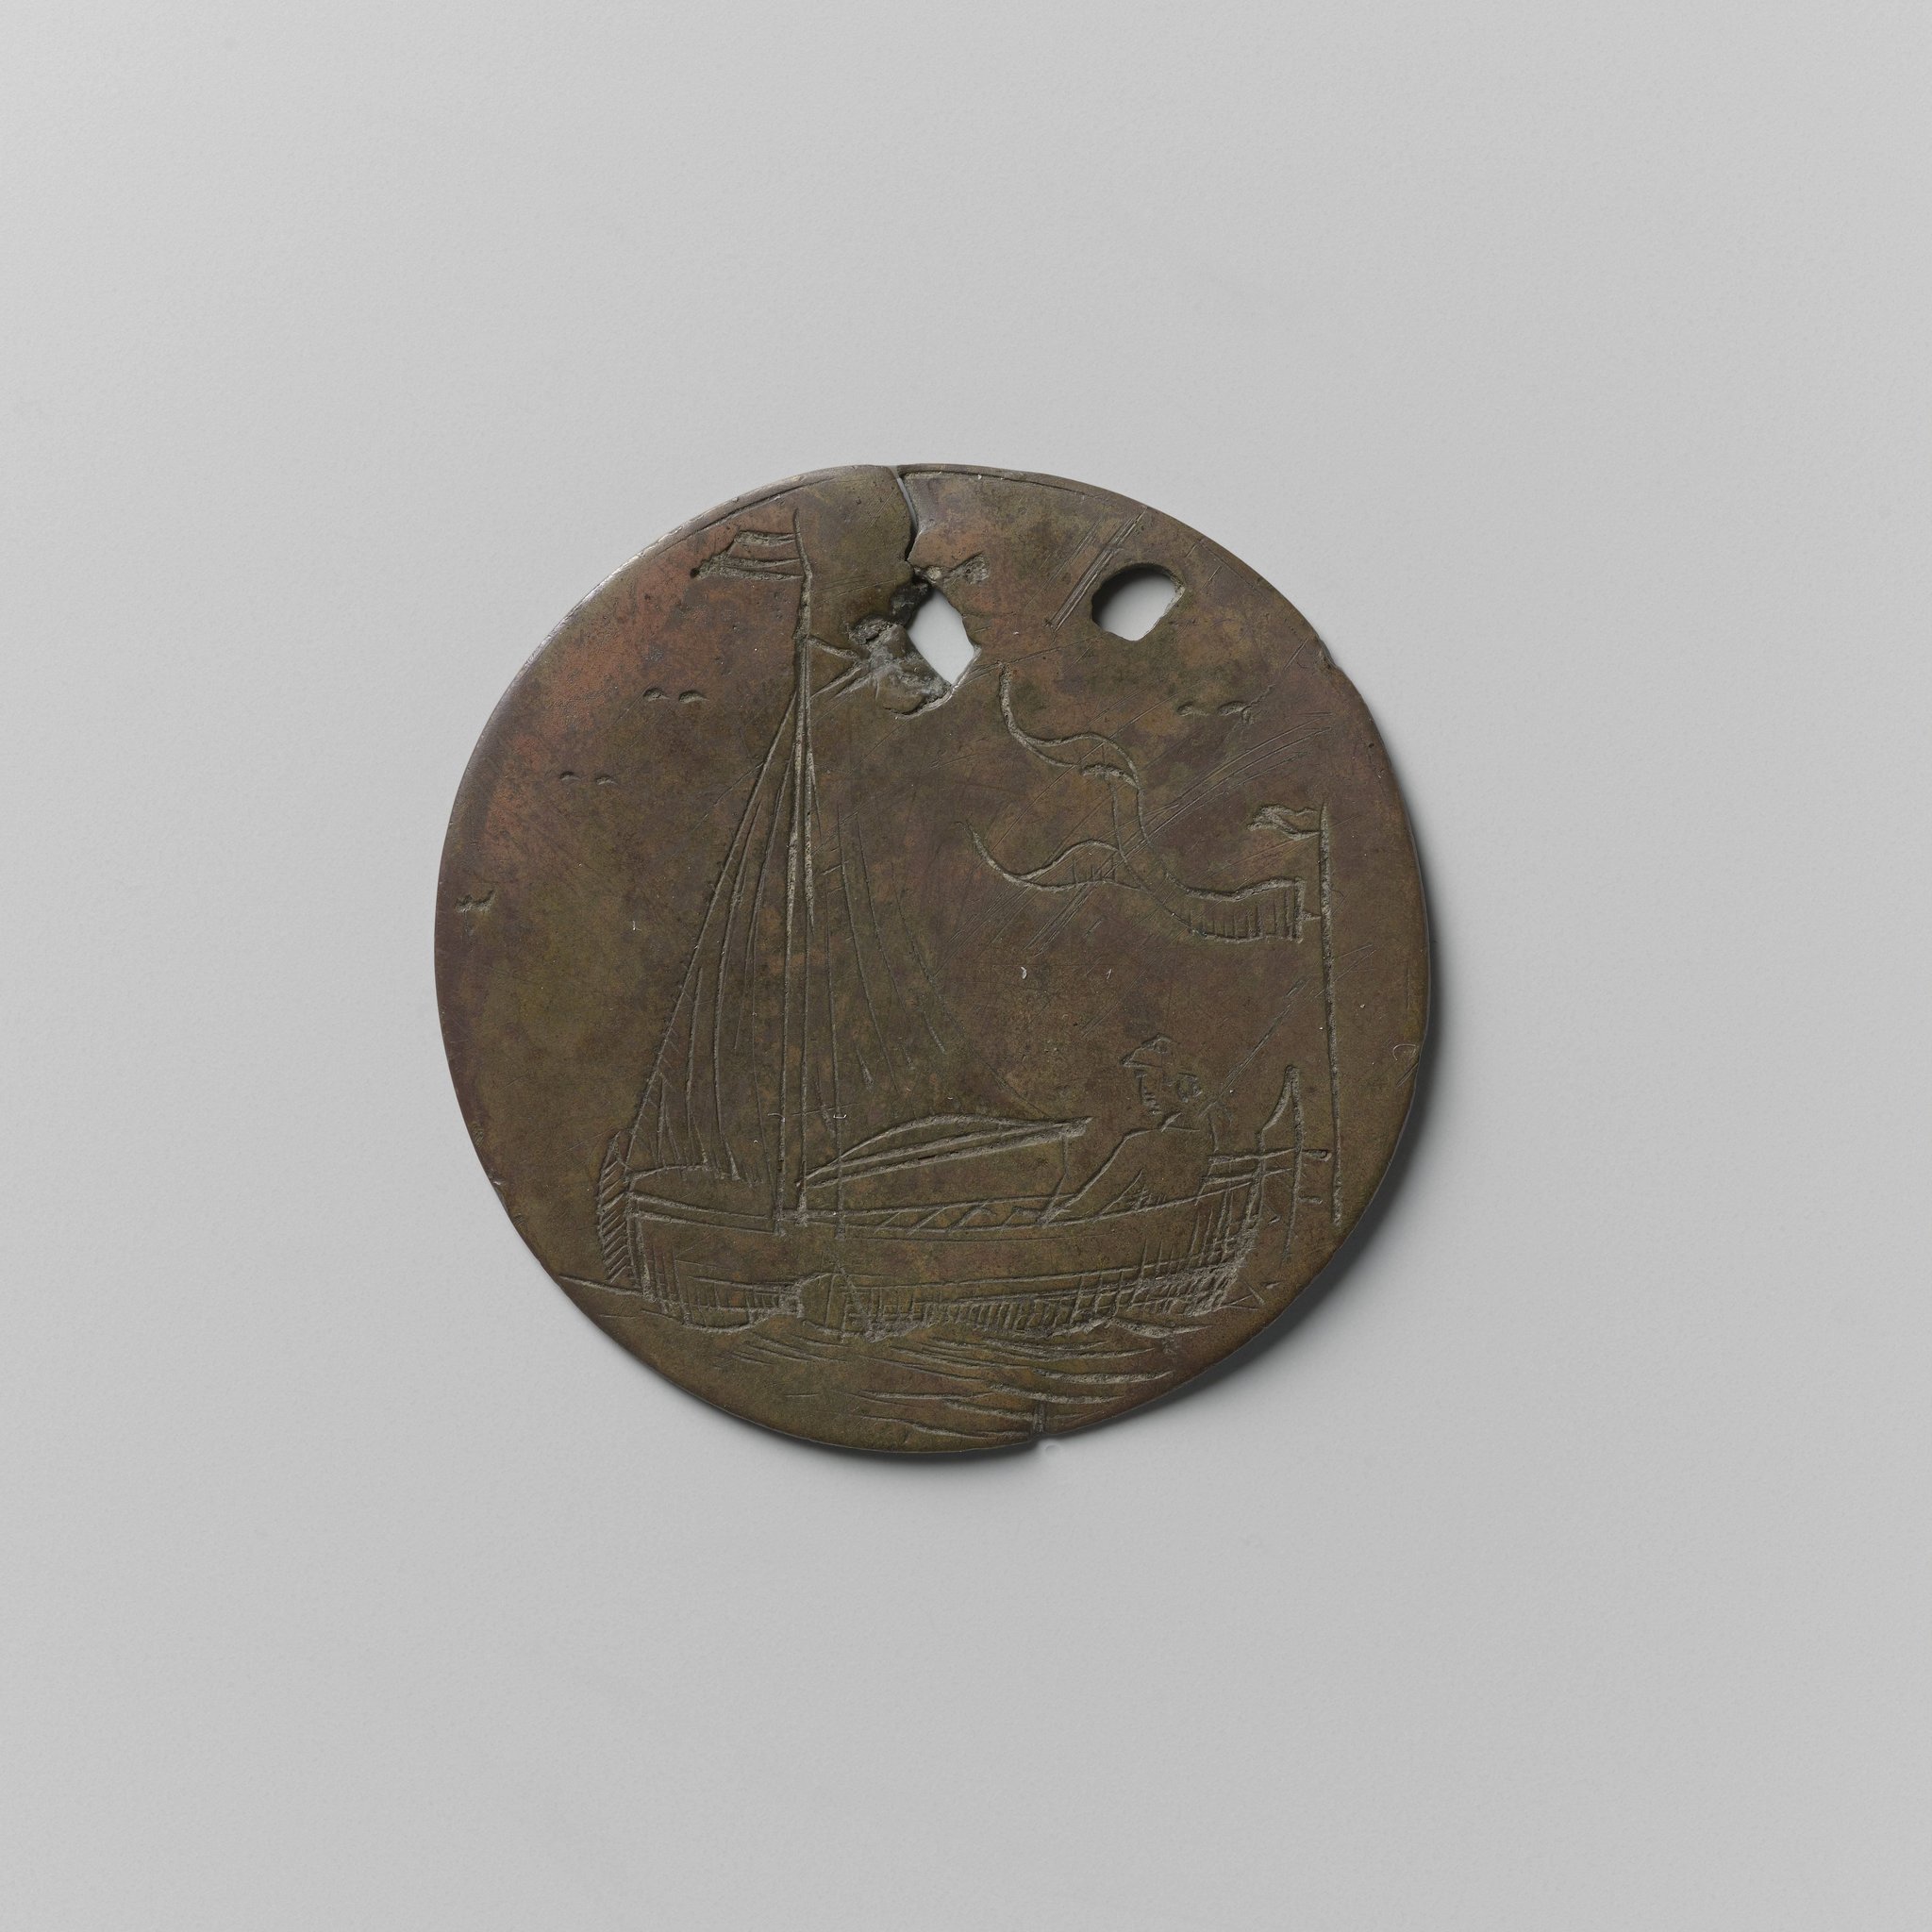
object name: medal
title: Roei-, steiger- en schuitenvoerdersgilde van Amsterdam, gildepenning van Jan Gerritse Vooren, ligplaats Lange Brug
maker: Anonymous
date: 1776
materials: brass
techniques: engraving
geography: amsterdam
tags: amsterdam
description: Messing penning met twee gaten erin. Voorzijde: naar links varende zeilboot; op achterplecht: zittende man en vlag. Keerzijde: opschrift boven huismerk en hart met daarin letters I, G en V tussen monogram van letters L en B